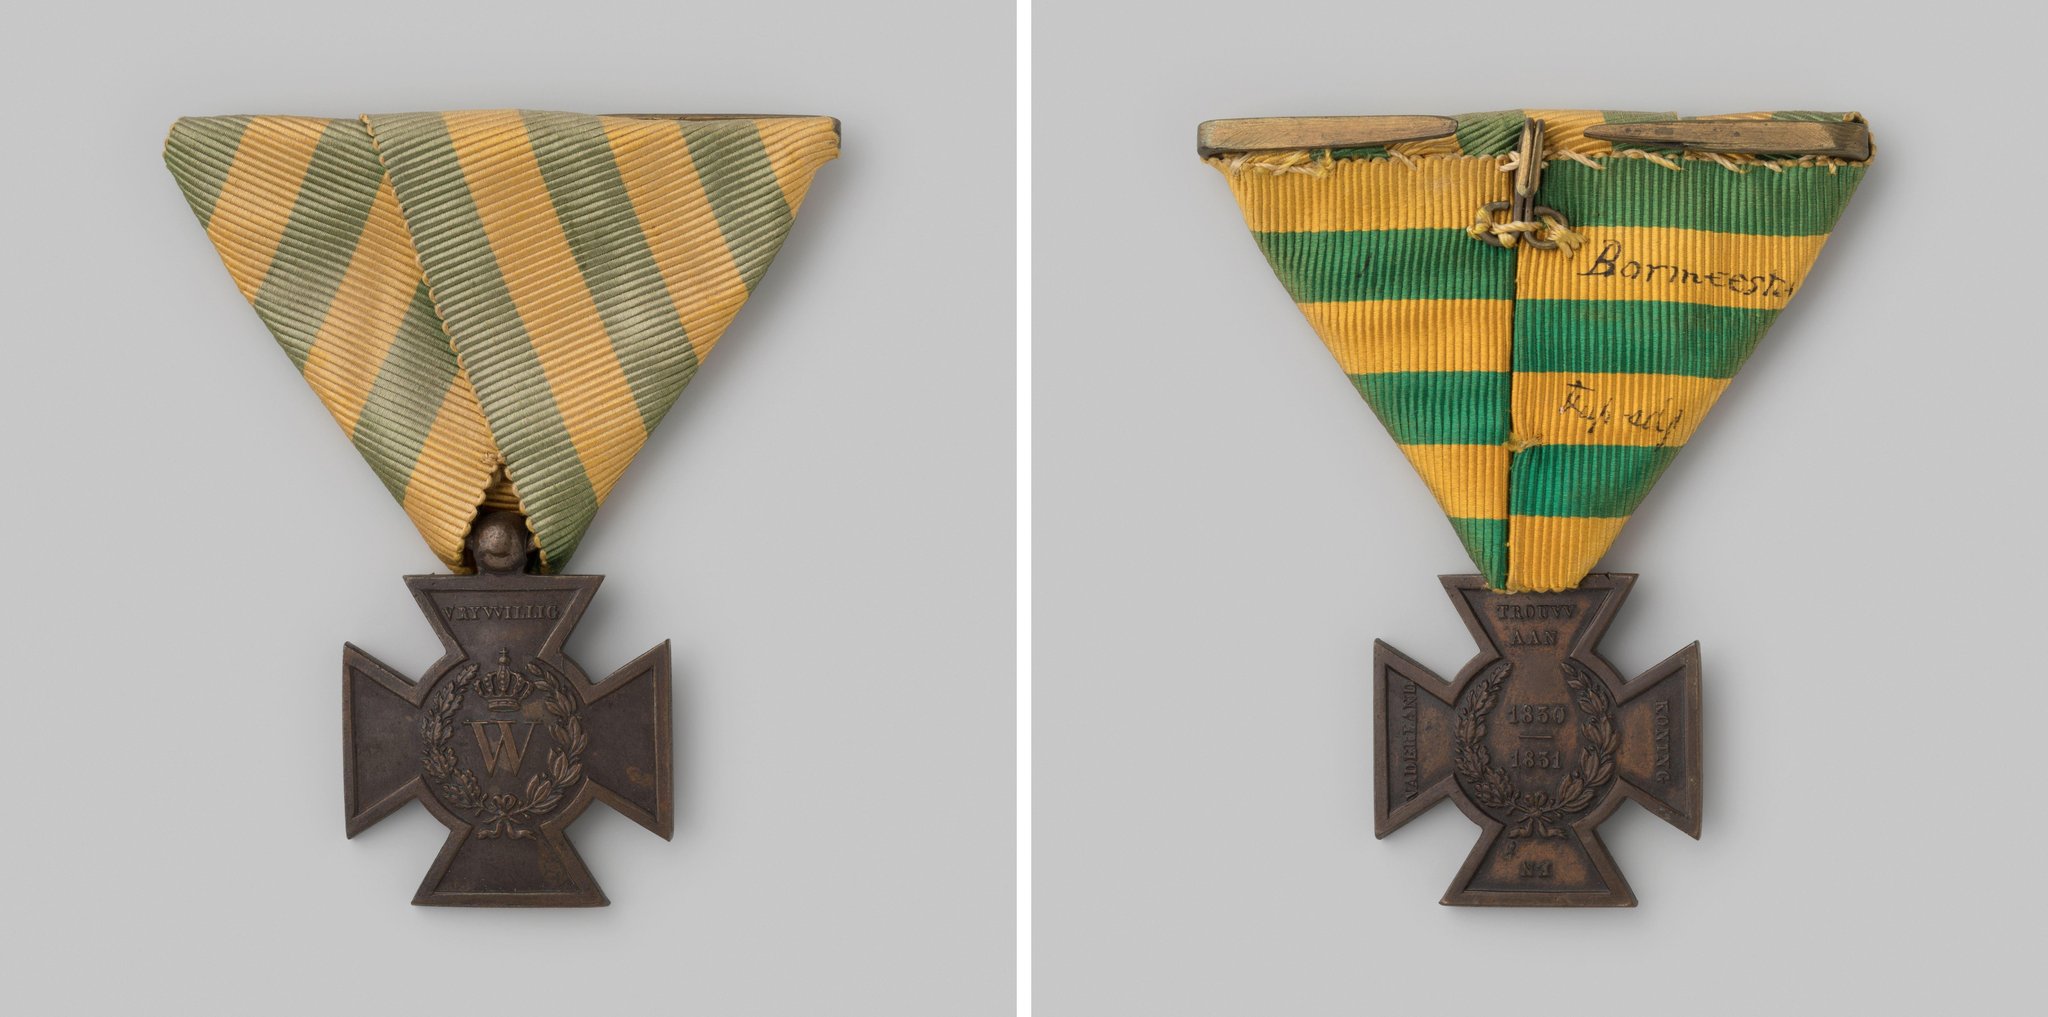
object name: insignia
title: Metalen Kruis Vrijwilligers 1830-1831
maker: Anonymous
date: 1831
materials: bronze, textile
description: Bronzen draagpenning met knop, ring en lint.